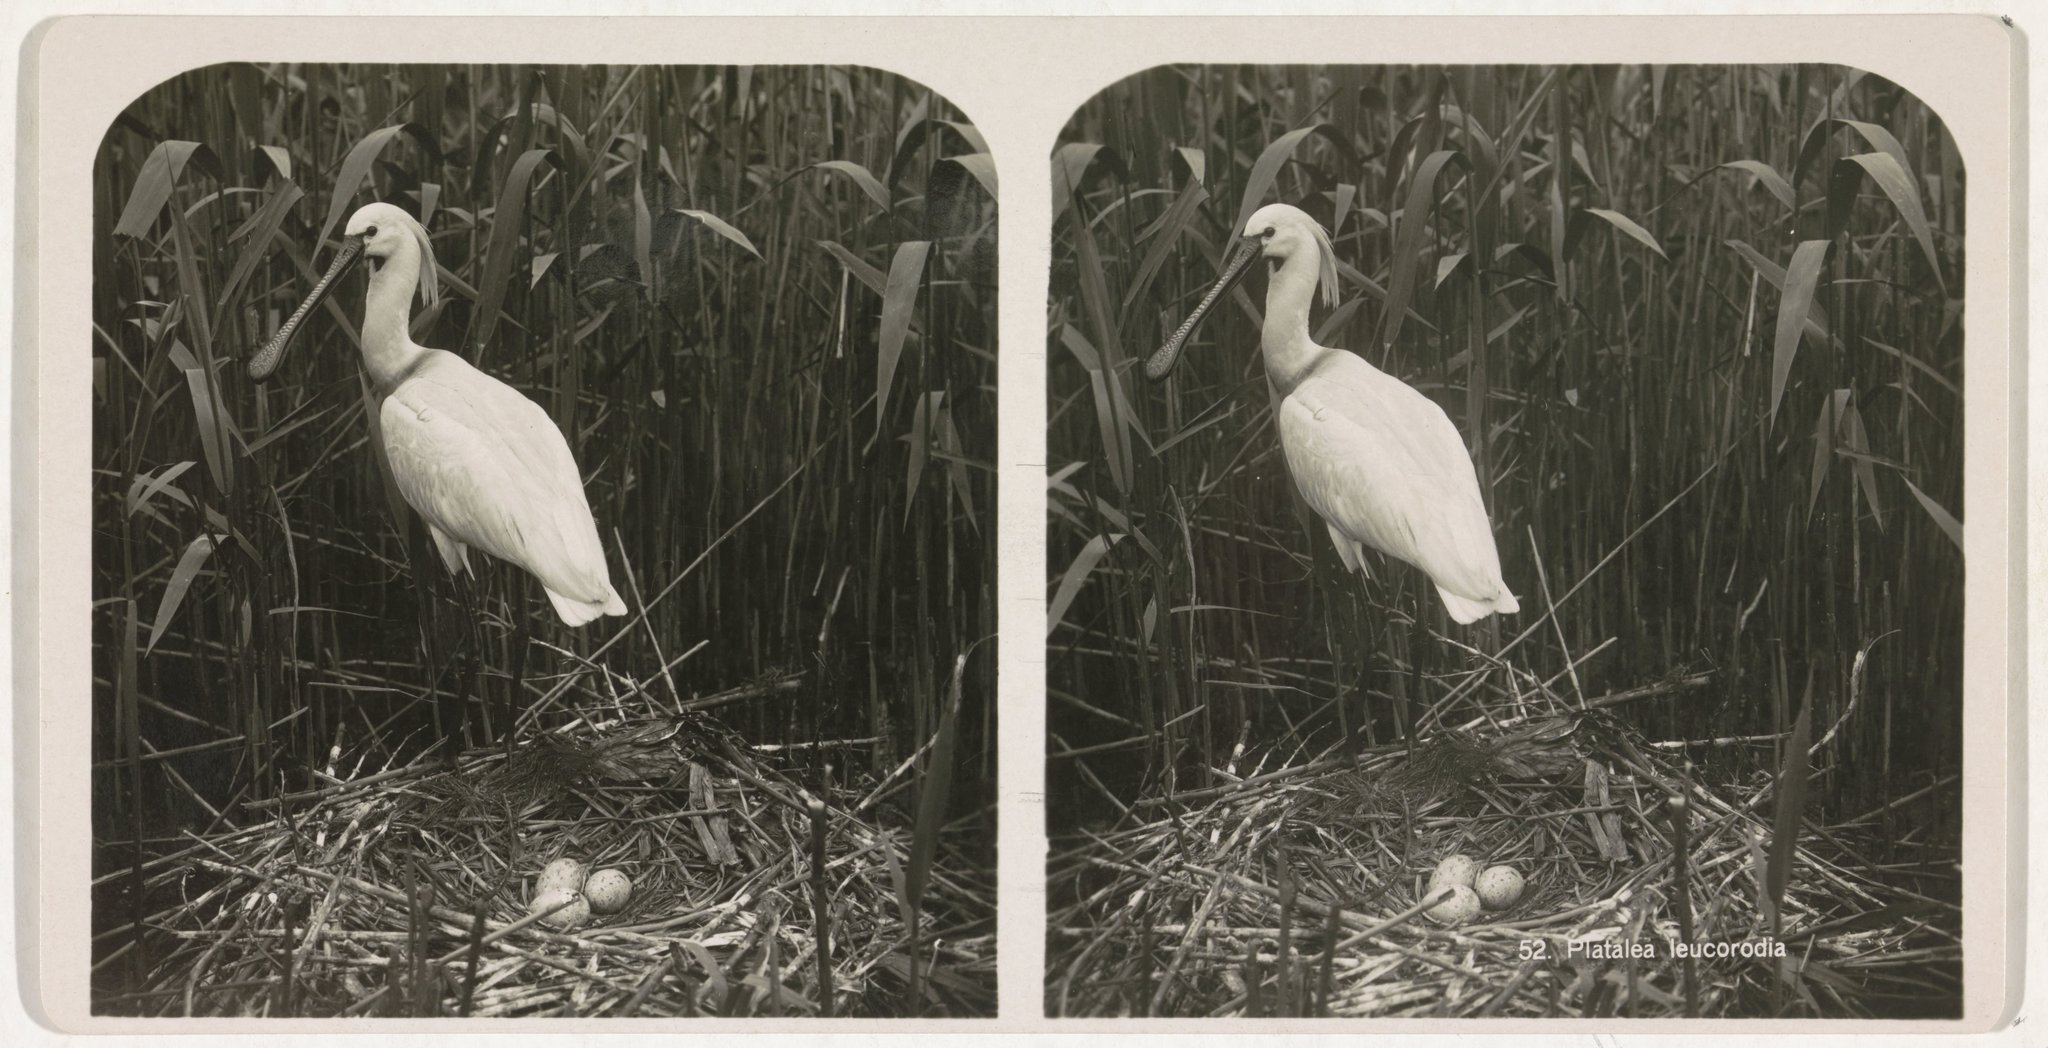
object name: stereograph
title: 52. Platalea leucorodia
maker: adolphe burdet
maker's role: fotograaf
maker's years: 1860-1940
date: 1870-1940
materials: photographic support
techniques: gelatin silver print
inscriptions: label: ‘Lepelaars’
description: De foto is afkomstig uit een serie van 12 stereofoto's met moerasvogels die bewaard worden in het originele mapje. Bij dit mapje zit ook een blaadje met gedrukte tekst dat informatie bevat over de vogels.